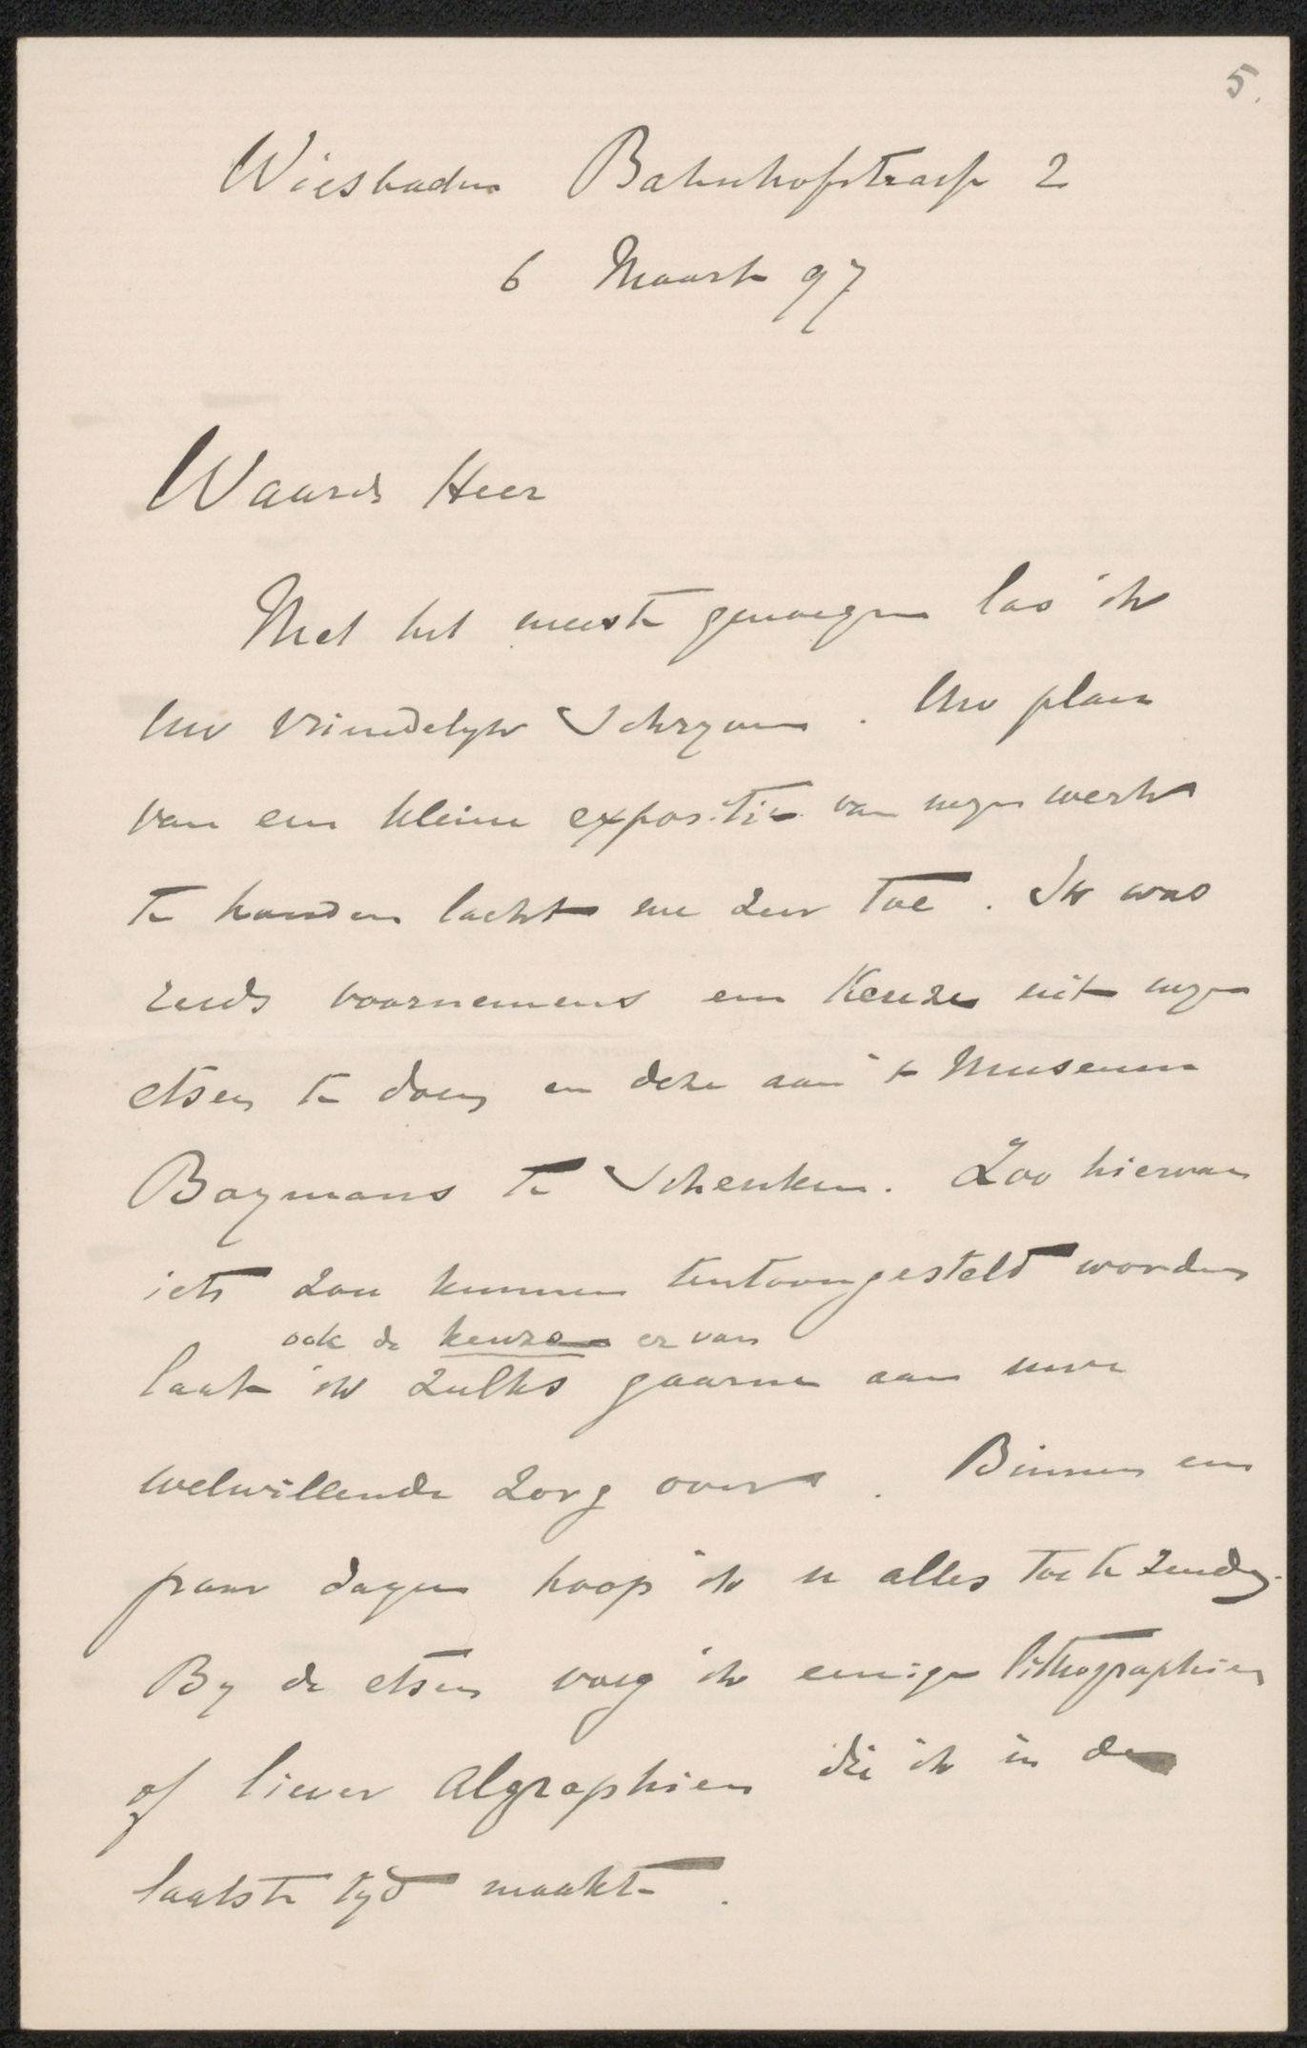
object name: letter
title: Brief aan Pieter Haverkorn van Rijsewijk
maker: carel nicolaas storm van s-gravesande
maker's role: draughtsman, print maker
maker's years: 1841-1924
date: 1897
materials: ink, paper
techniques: pen, writing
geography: wiesbaden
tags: publisher, pieter haverkorn van rijsewijk, the graphic arts, exhibition ~ art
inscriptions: collector's mark: ‘RPK’